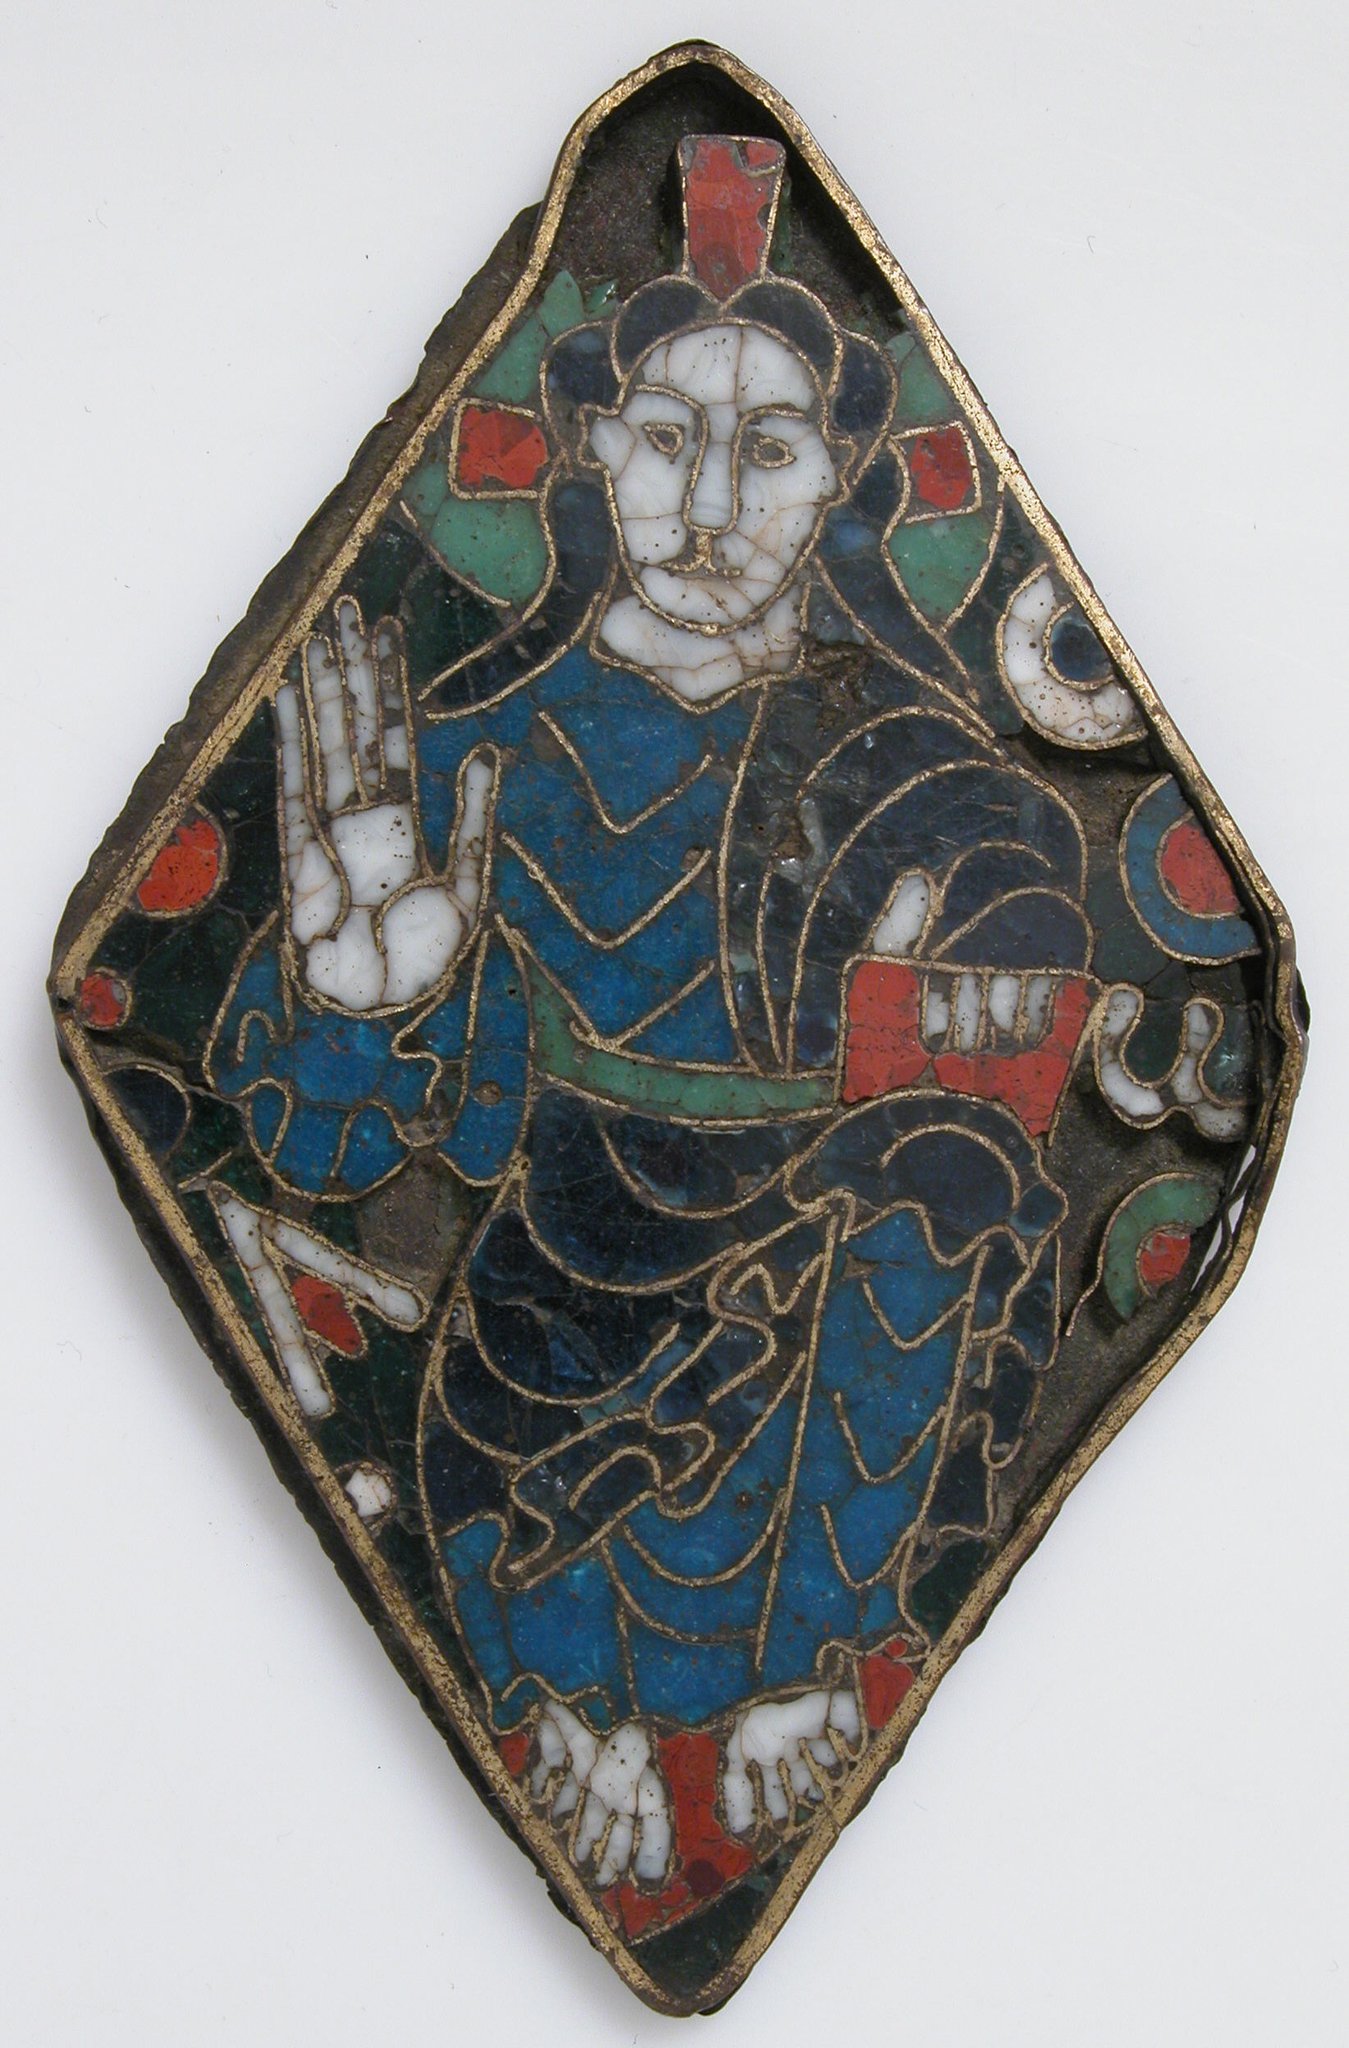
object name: plaque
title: Plaque with Christ in Majesty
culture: south french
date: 1050-1100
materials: alloy, enamel, gilt copper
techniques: enamel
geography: france